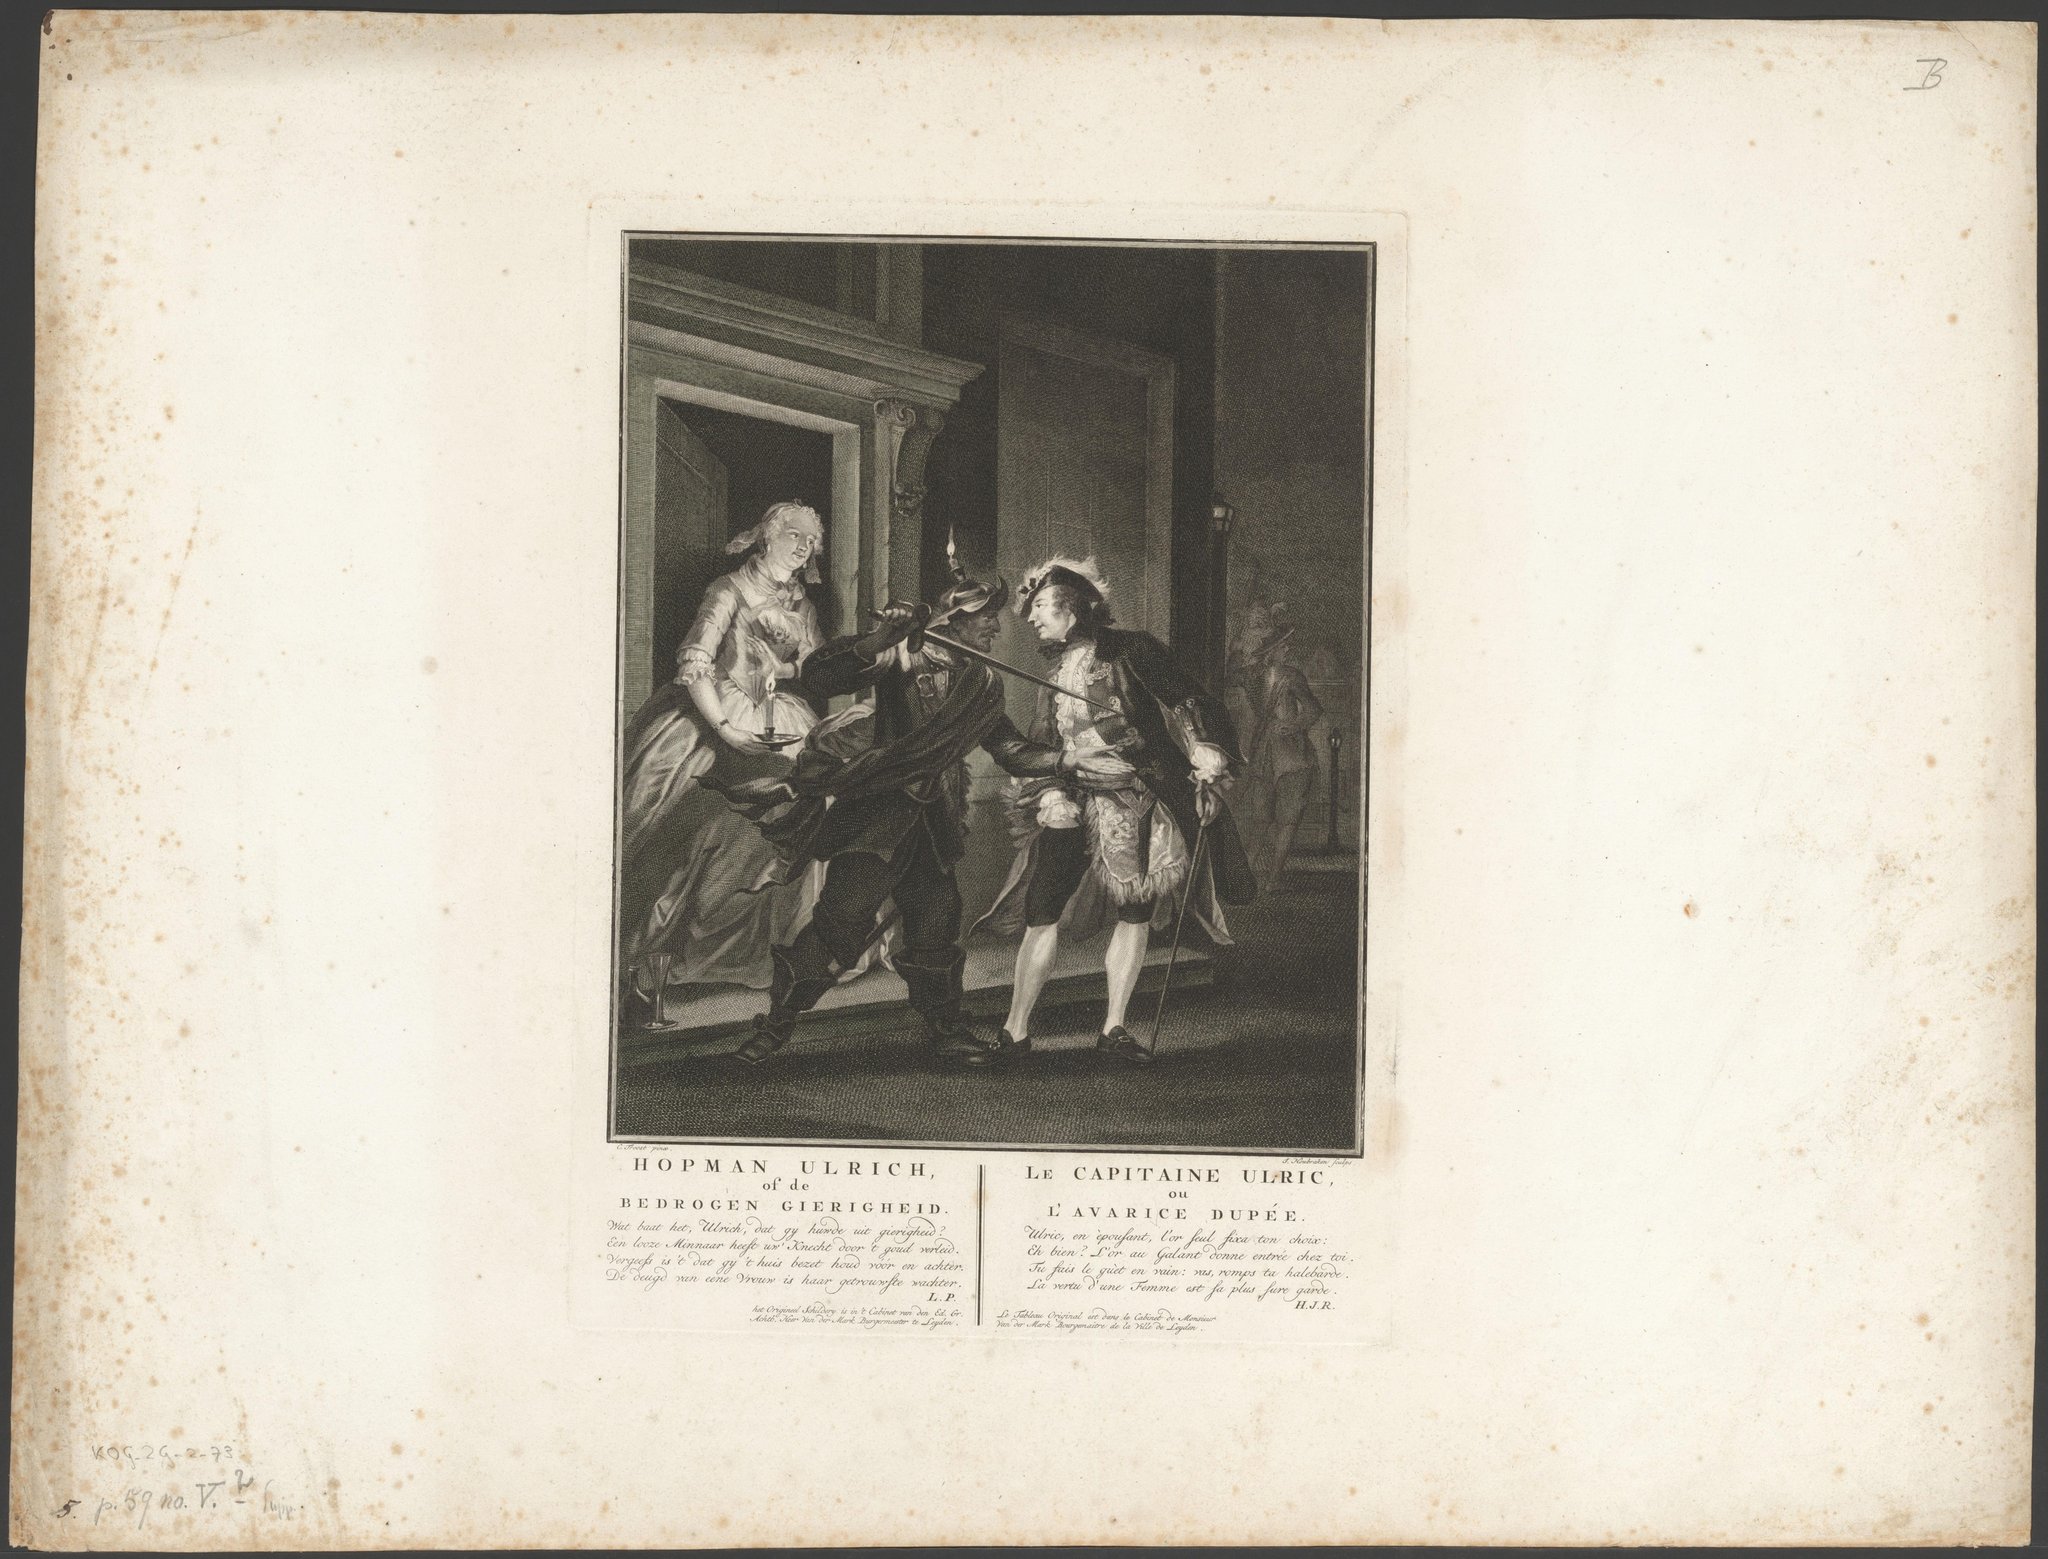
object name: print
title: Hopman Ulrich of de Bedrogen Gierigheid: de omkoping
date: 1760-1780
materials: paper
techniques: engraving, etching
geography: amsterdam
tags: comedy, candlestick, guard duty, keeping sentry, night, bribery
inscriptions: collector's mark: Lugt 2488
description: Een wachter met een zwaard vraagt een jongeman (Godefroy), die heimelijk in de nacht bij zijn geliefde (Sybille) op bezoek komt, om geld. De jongeman steekt zijn hand in zijn broekzak. De vrouw heeft een kaars vast. Op de stoep staan een glas en een fles. Rechts op de achtergrond een tweede wachter. Scène uit het blijspel 'Hopman Ulrich of de bedrogen gierigheid' van Johan van Paffenrode uit 1661, waarin het gierige personage Ulrich wordt bedrogen door zijn vrouw Sybille, ondanks dat hij haar laat bewaken. Haar minnaar Godefroy koopt de wachter om. In de marge twee vierregelige verzen in het Nederlands en het Frans.